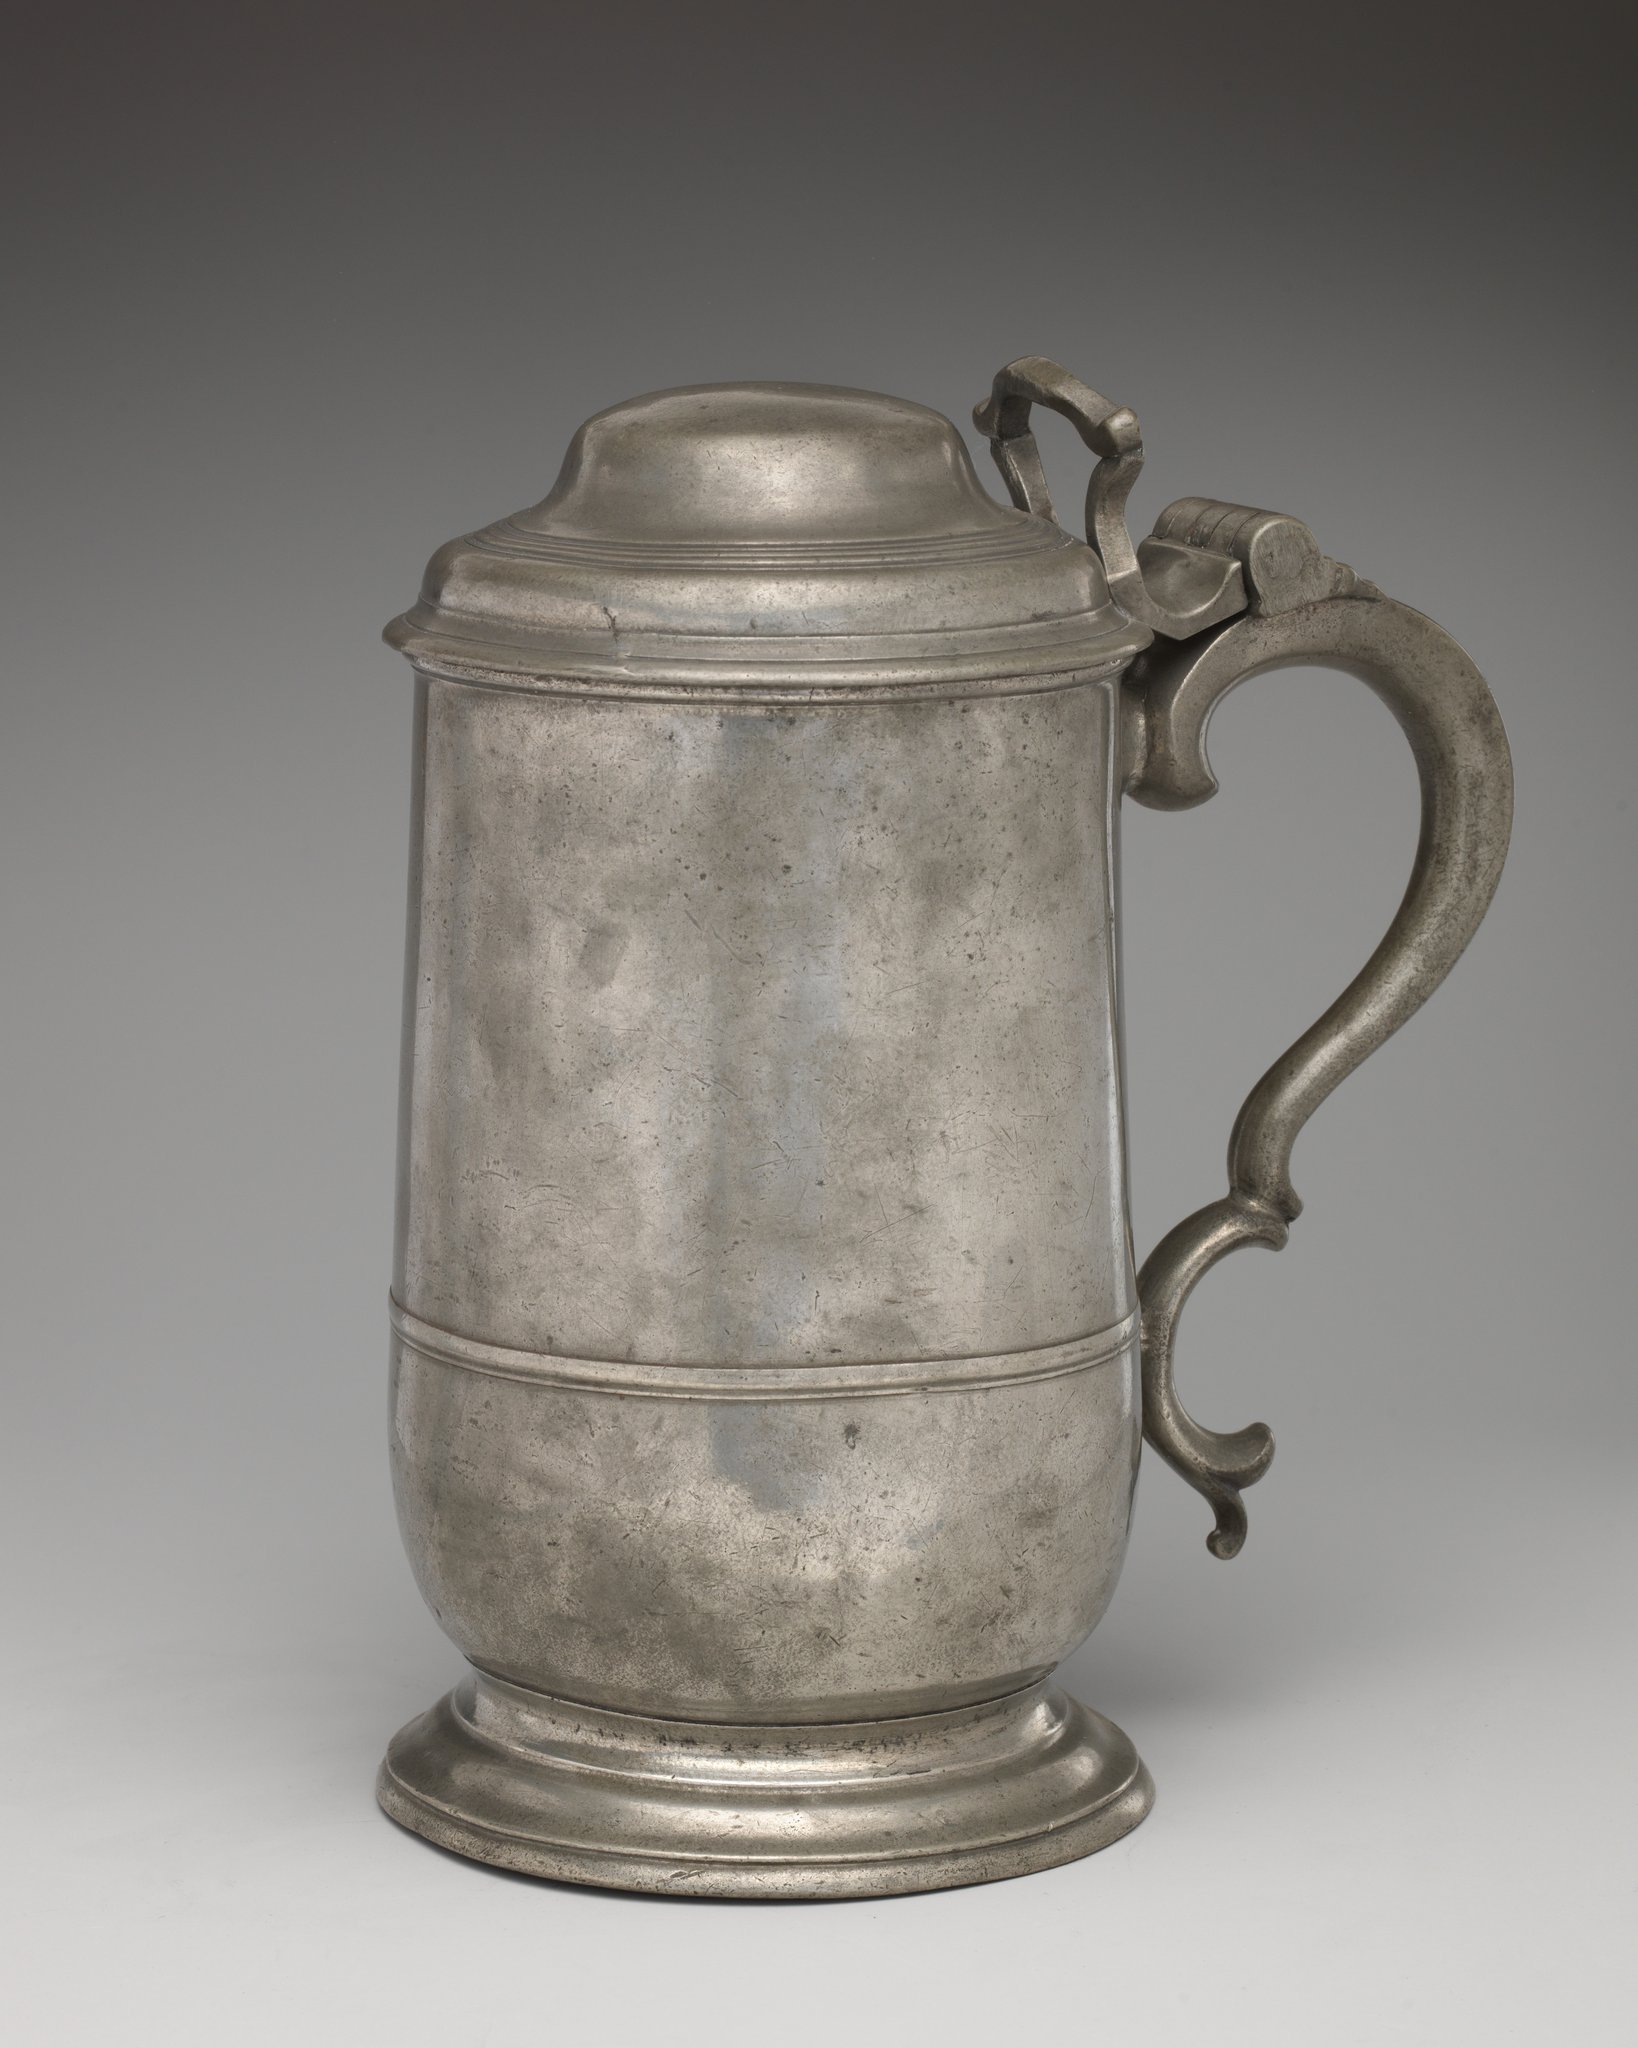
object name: communion flagon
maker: townsend and compton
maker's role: maker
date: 1801-1900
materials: pewter